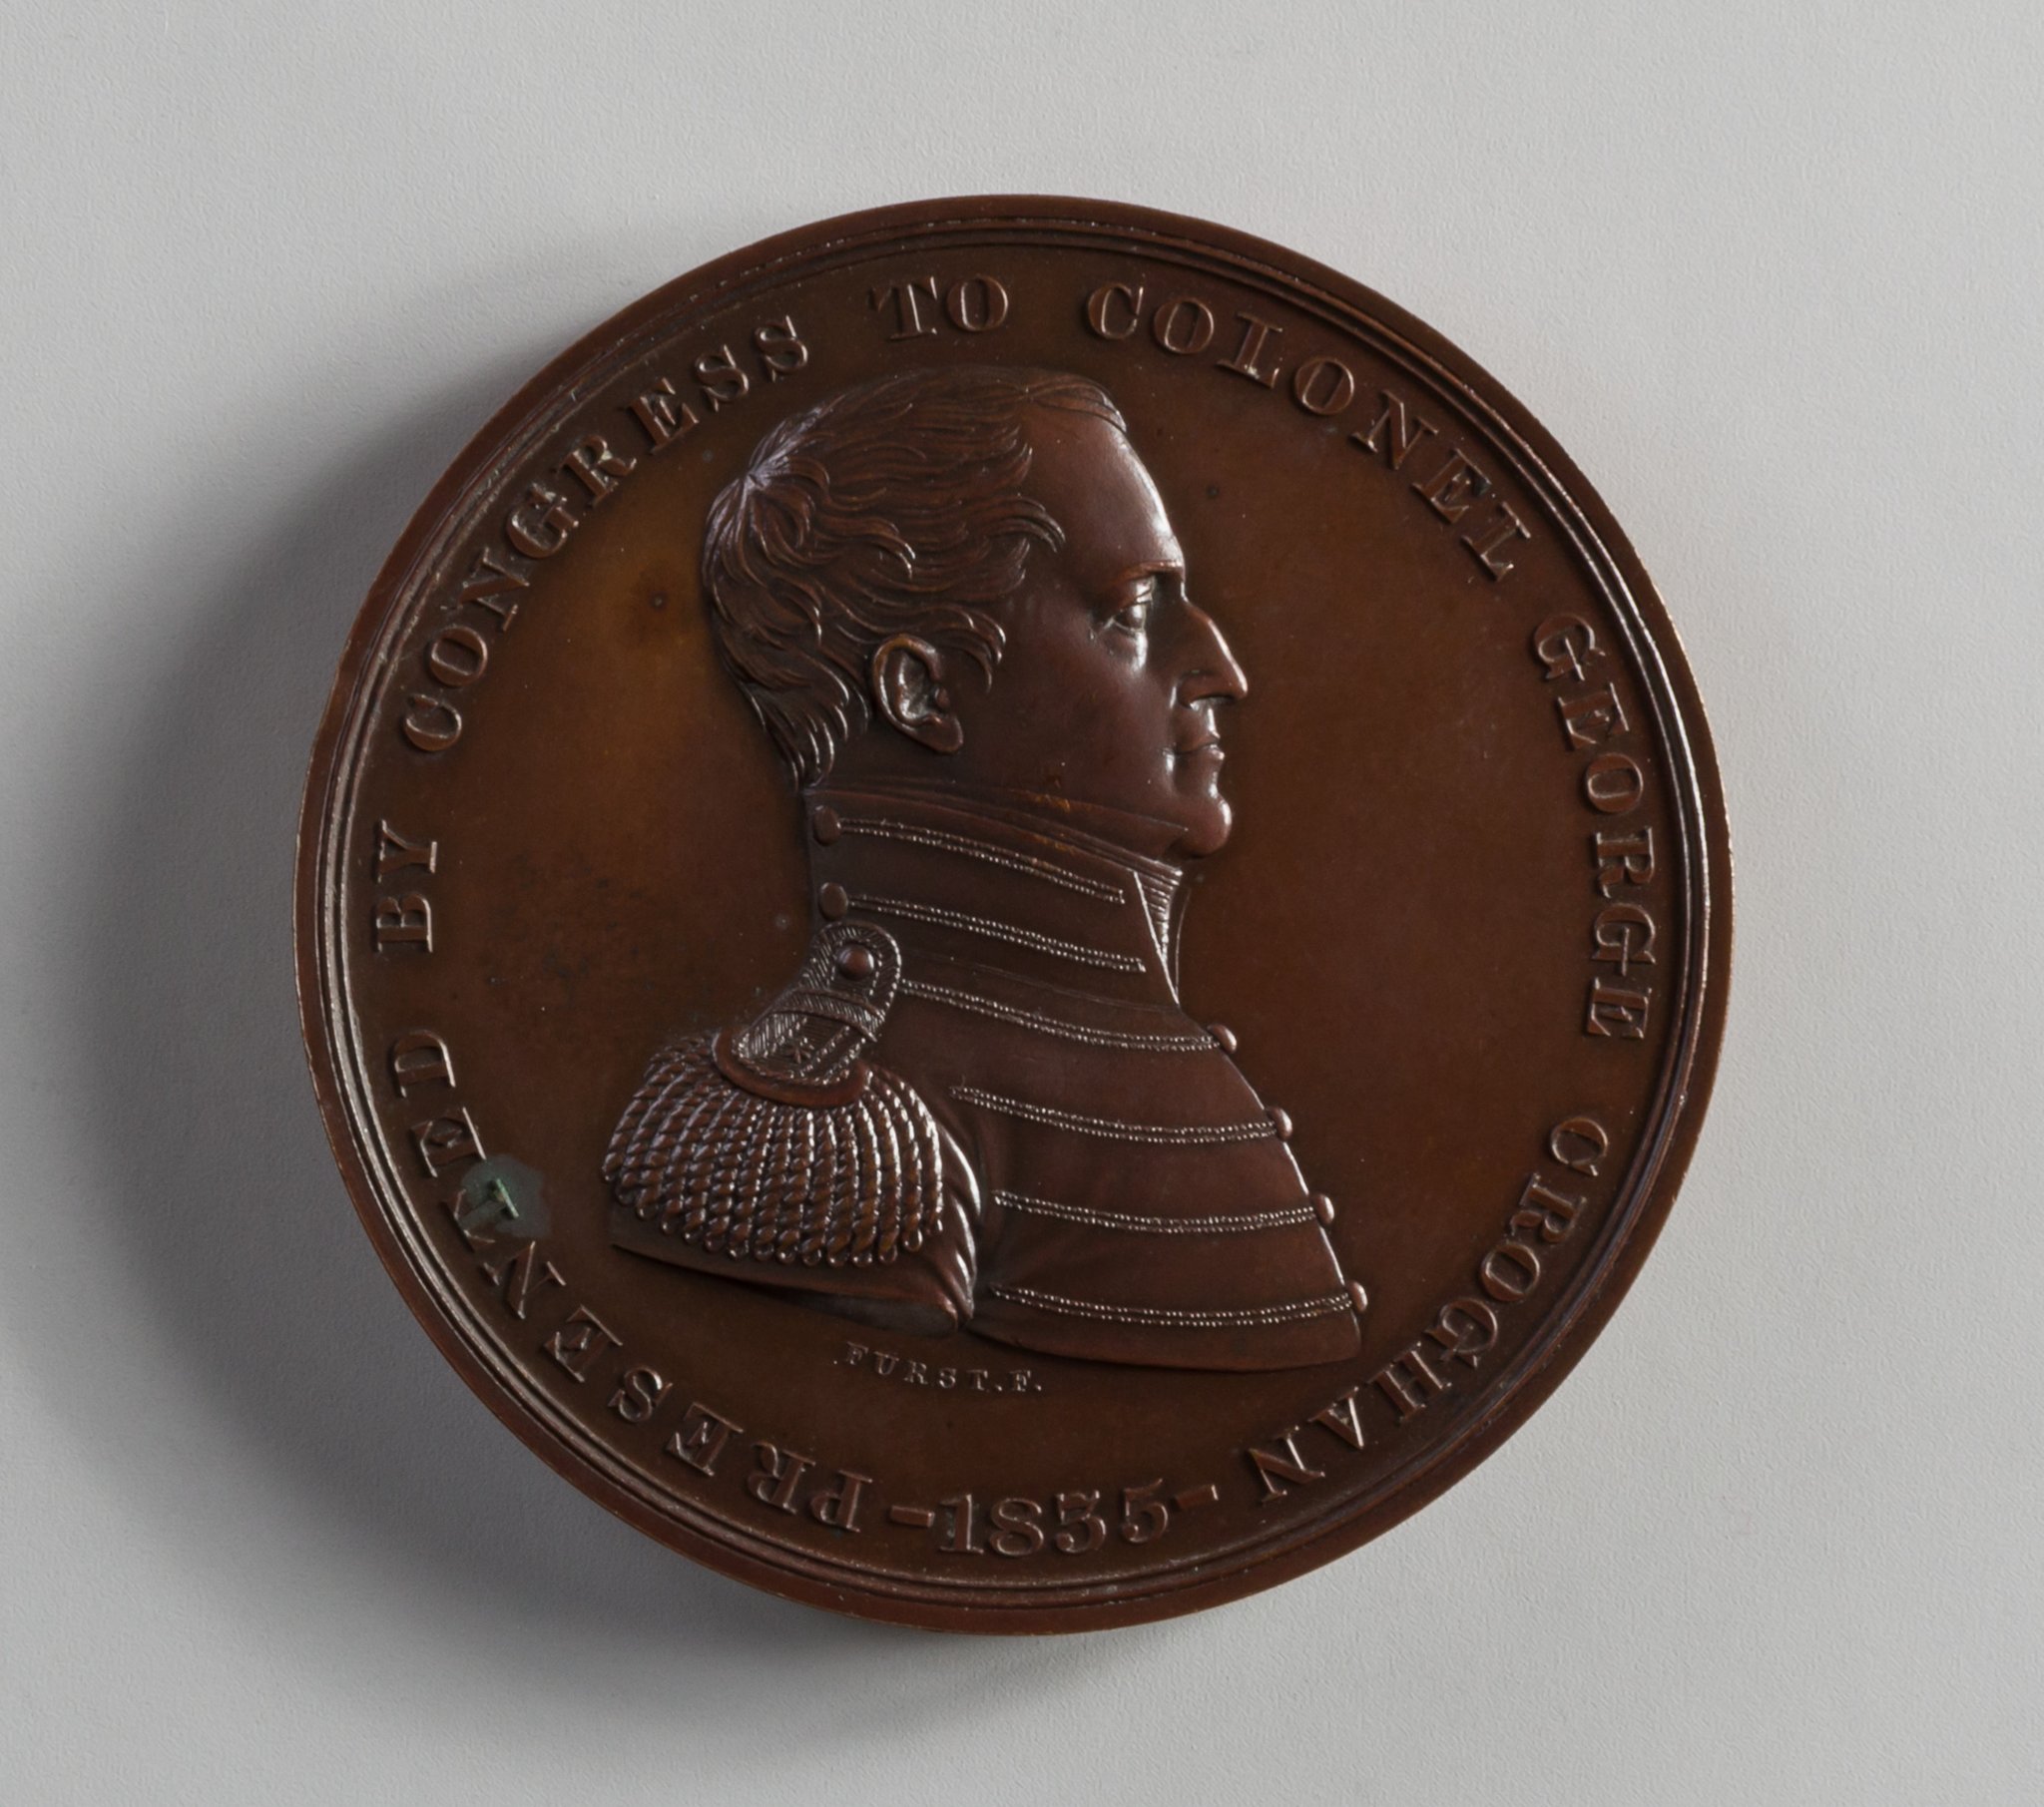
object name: medal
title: Medal of Colonel George Croghan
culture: american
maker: moritz fürst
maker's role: maker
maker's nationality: hungarian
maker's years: 1782-1882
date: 1800-1830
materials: bronze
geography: united states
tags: men,profiles